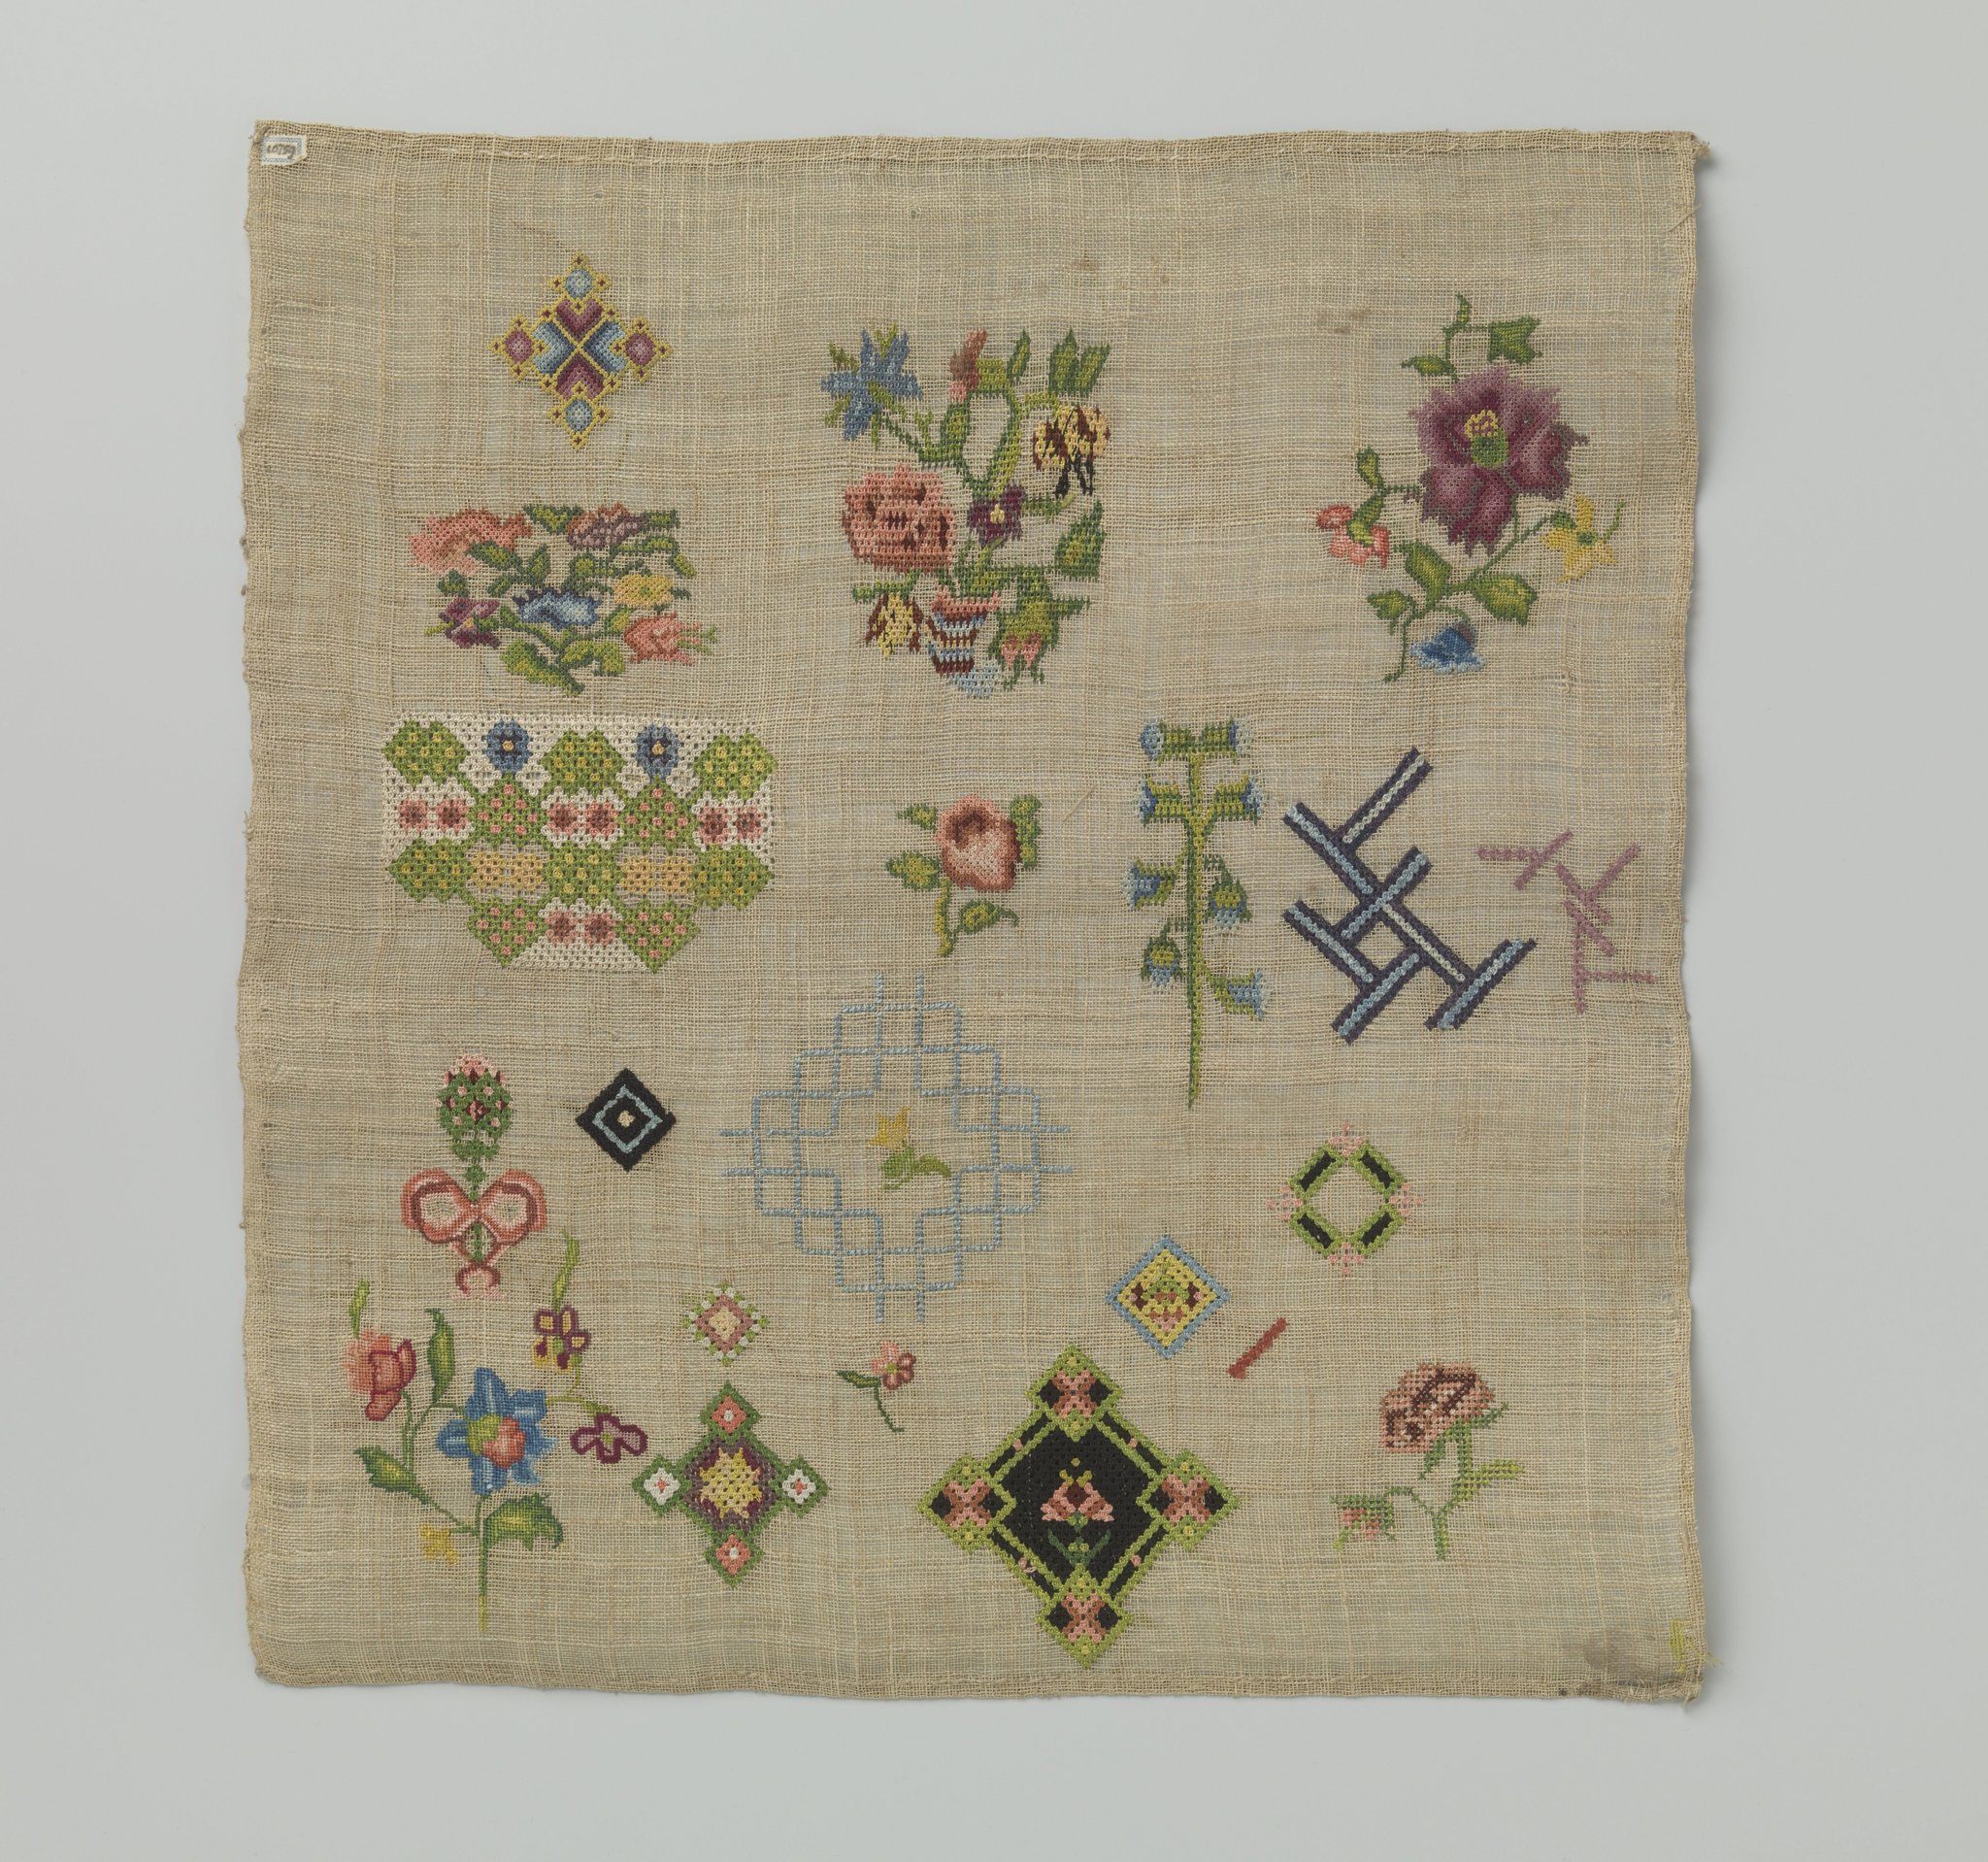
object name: merkdoek, merklap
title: Borduurlap van beige getint linnen. Het borduurwerk heeft petit point met rococo-steek. De merklap maakt deel uit van negen merklappen van verschillende grootten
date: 1760-1780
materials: linen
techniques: embroidered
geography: south holland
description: Borduurlap van beige getint linnen. Het borduurwerk heeft petit point met rococo-steek. De merklap maakt deel uit van negen merklappen van verschillende grootten (BK-NM-10759-A t/m BK-NM-10759-I).